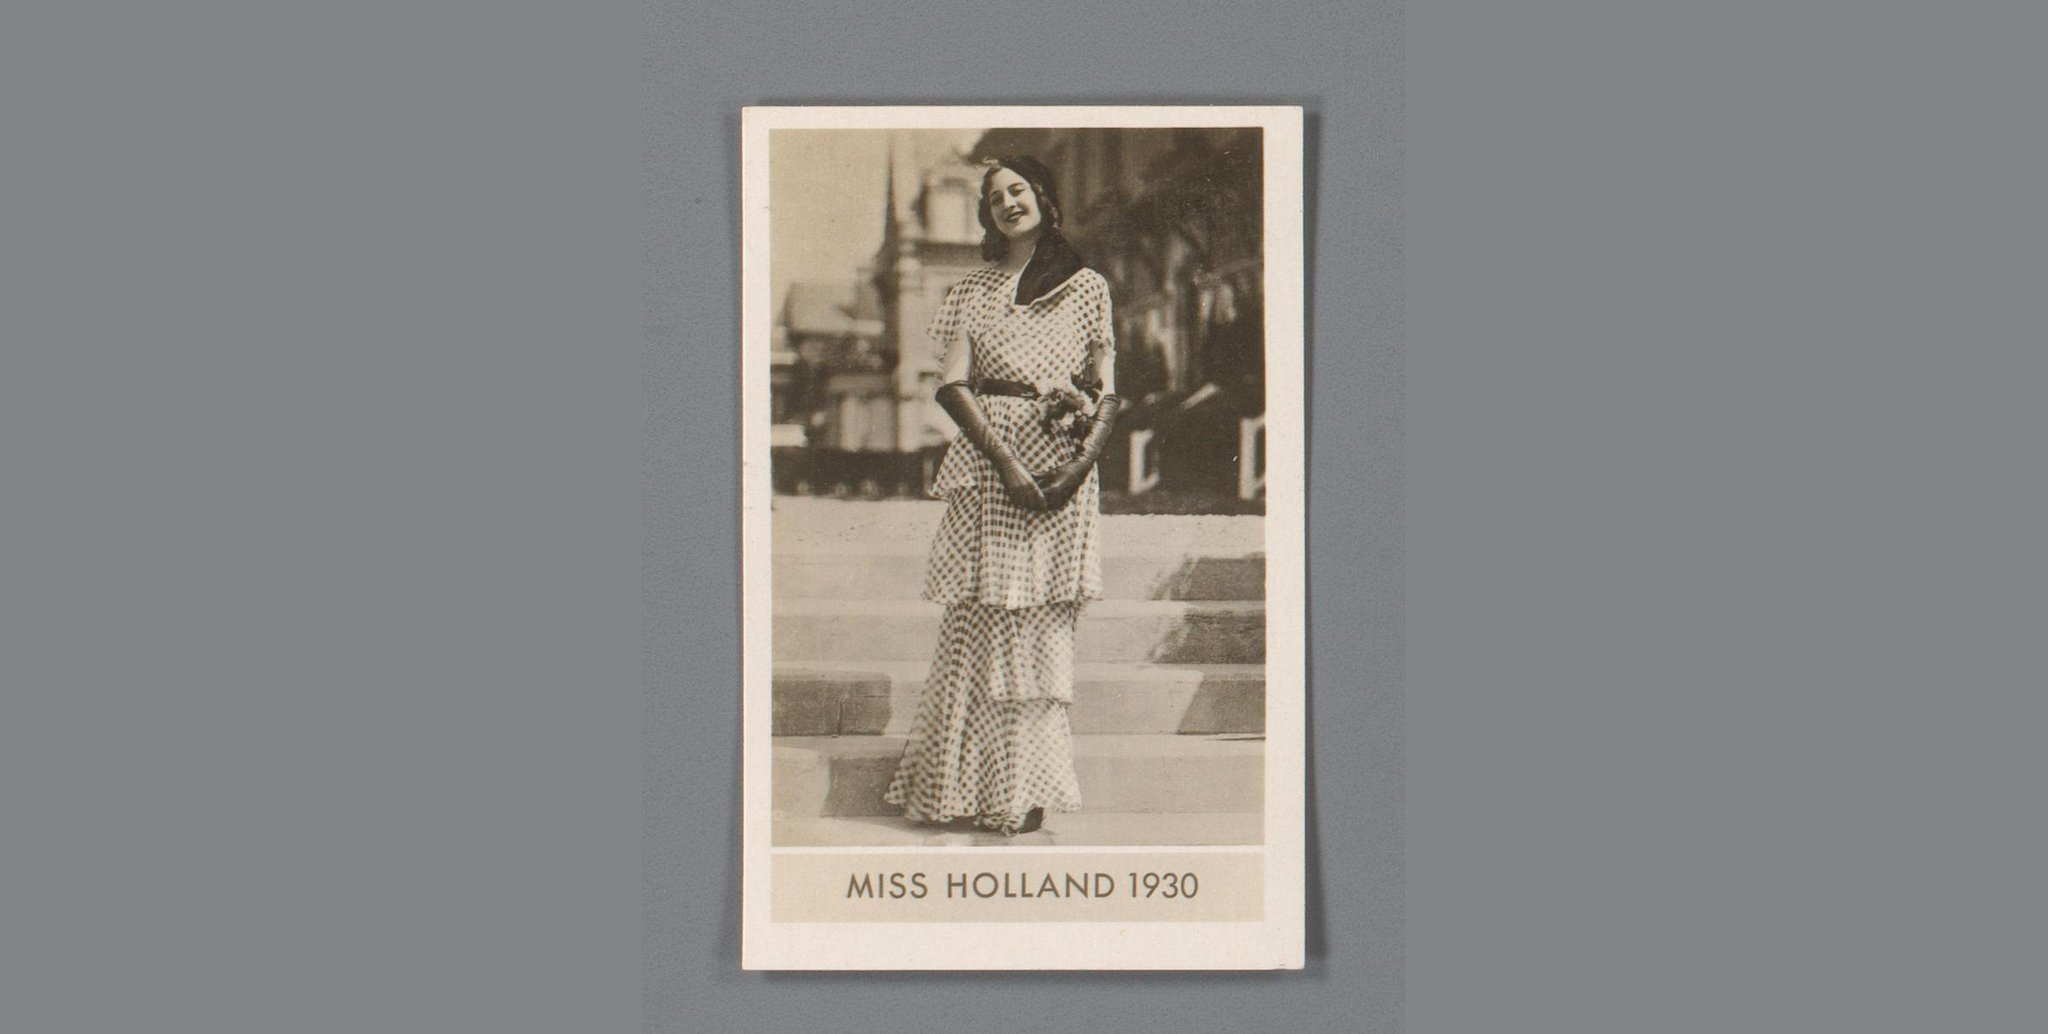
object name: photograph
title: Miss Holland 1930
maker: Anonymous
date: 1930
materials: paper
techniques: gelatin silver print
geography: dresden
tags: historical persons - bb - woman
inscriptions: inscription: ‘Die schönsten/ Frauen der Welt/ dargestellt durch die Schön-/ heitsköniginnen aller Länder,/ finden Sie in 190 echten/ Bromsilber-Fotos, die nur den/ CLUB-und-LIGA-Packun-/ gen beiliegen. Eind prächtiges/ Sammel-Album erhalten Sie/ für 75 Pfennig vom Händler/ oder bei Einsendung von/ 75 Pfennig in Briefmarken/ von der Bilderstelle Lohse,/ Dresden A24, Nossener Str. 1./ Ges. gesch. Nachdruck verboten!’